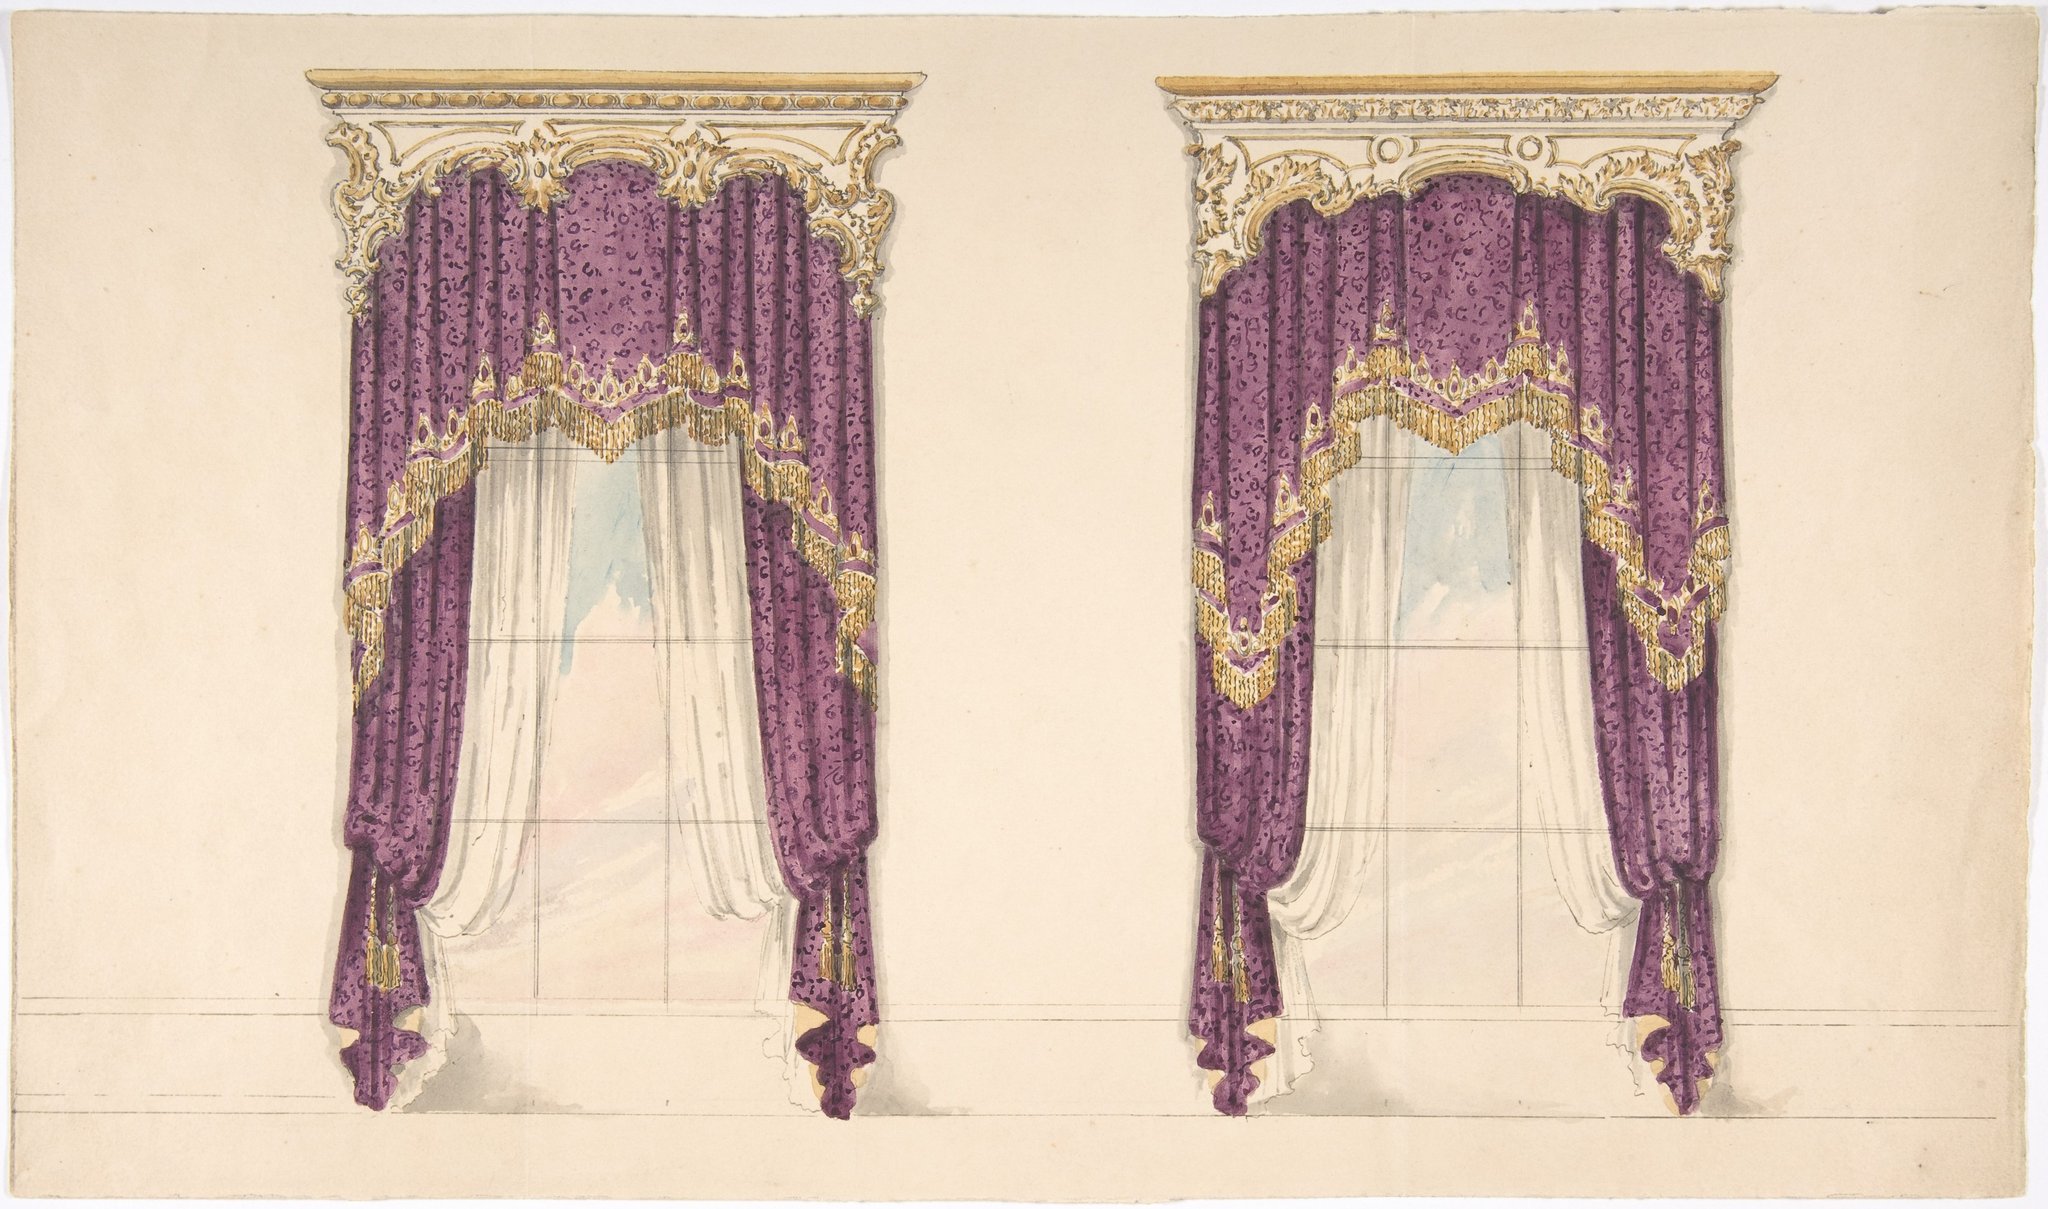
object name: drawing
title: Design for Purple Curtains with Gold Fringes and a Gold and White Pediment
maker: anonymous, british, 19th century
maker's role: artist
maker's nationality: british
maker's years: 1800-1900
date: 1801-1833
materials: ink, watercolor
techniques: brush, pen, wash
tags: windows,curtains